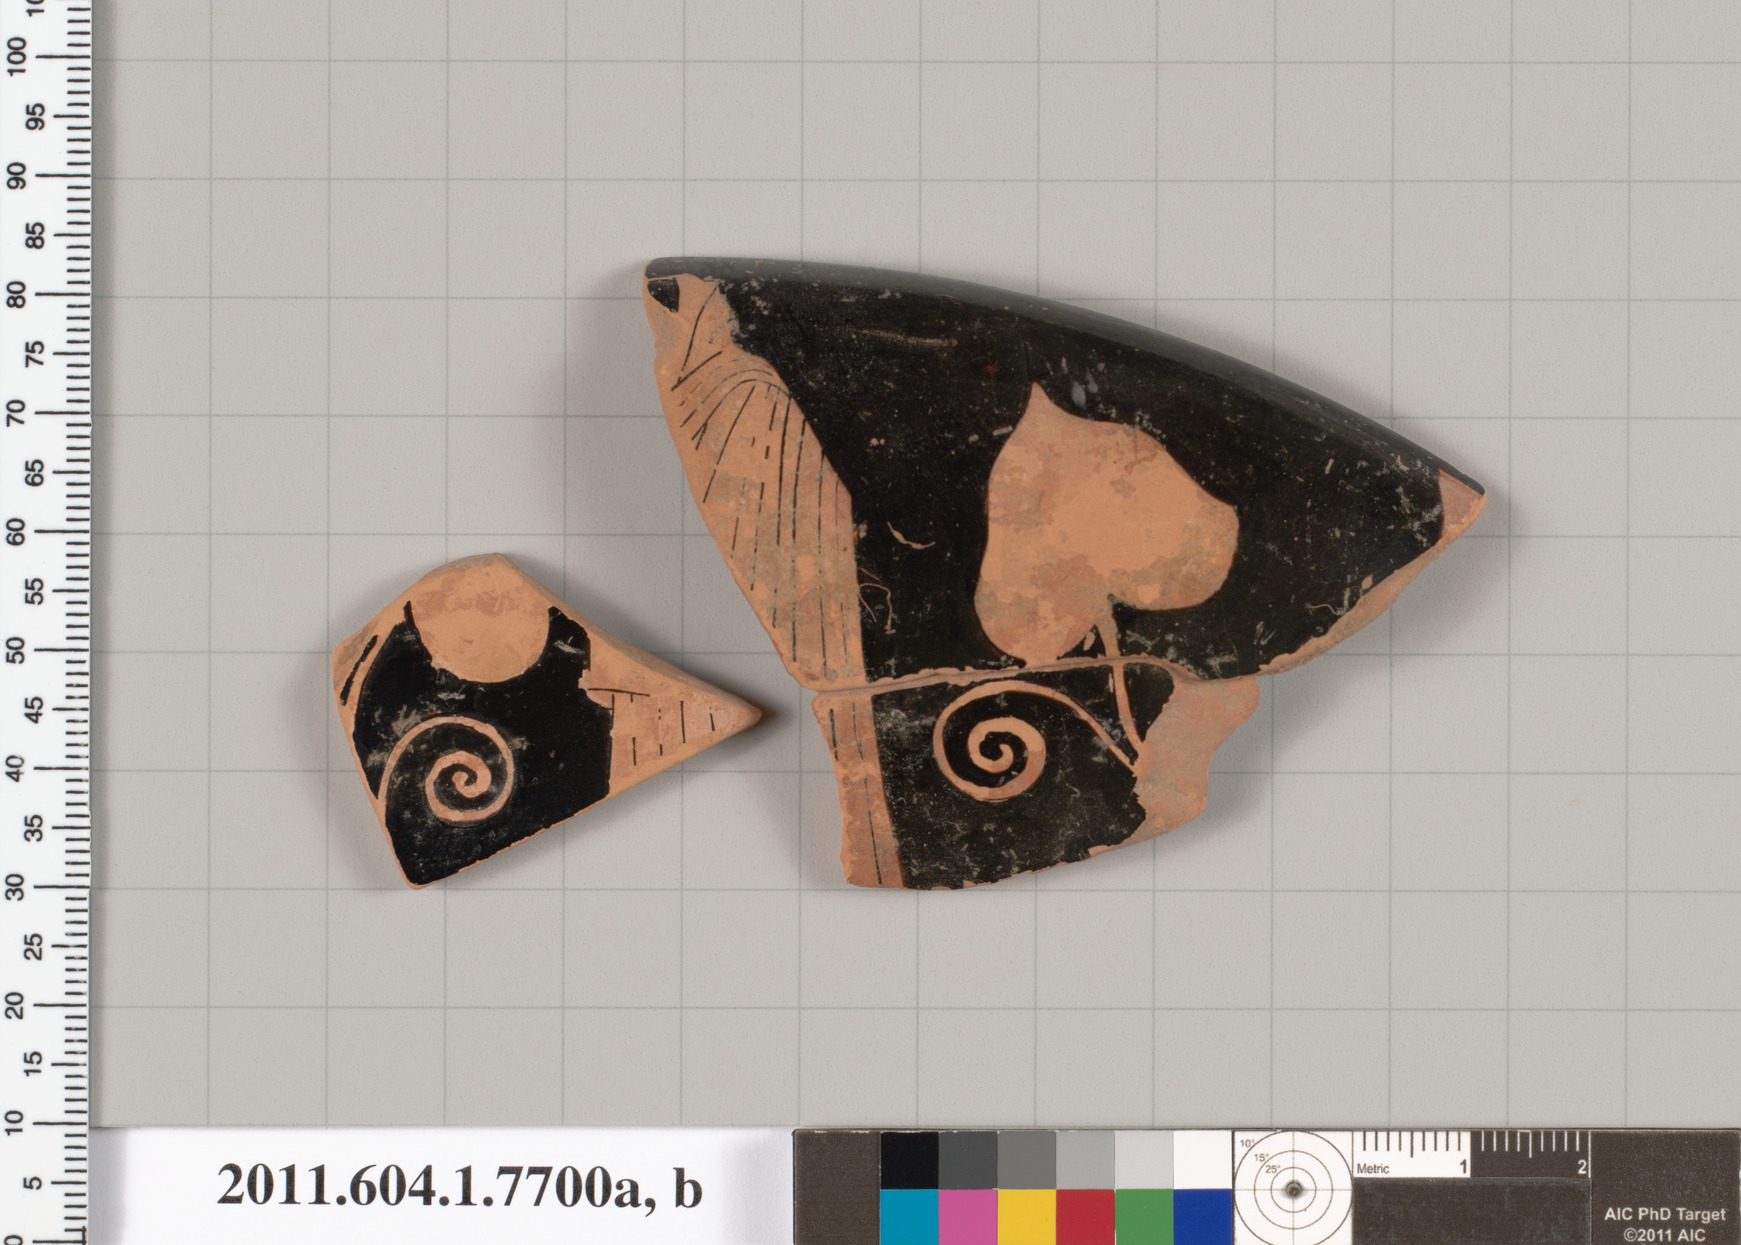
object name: kylix fragment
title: Terracotta rim fragments of a kylix (drinking cup)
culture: greek, attic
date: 470-460 BCE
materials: terracotta